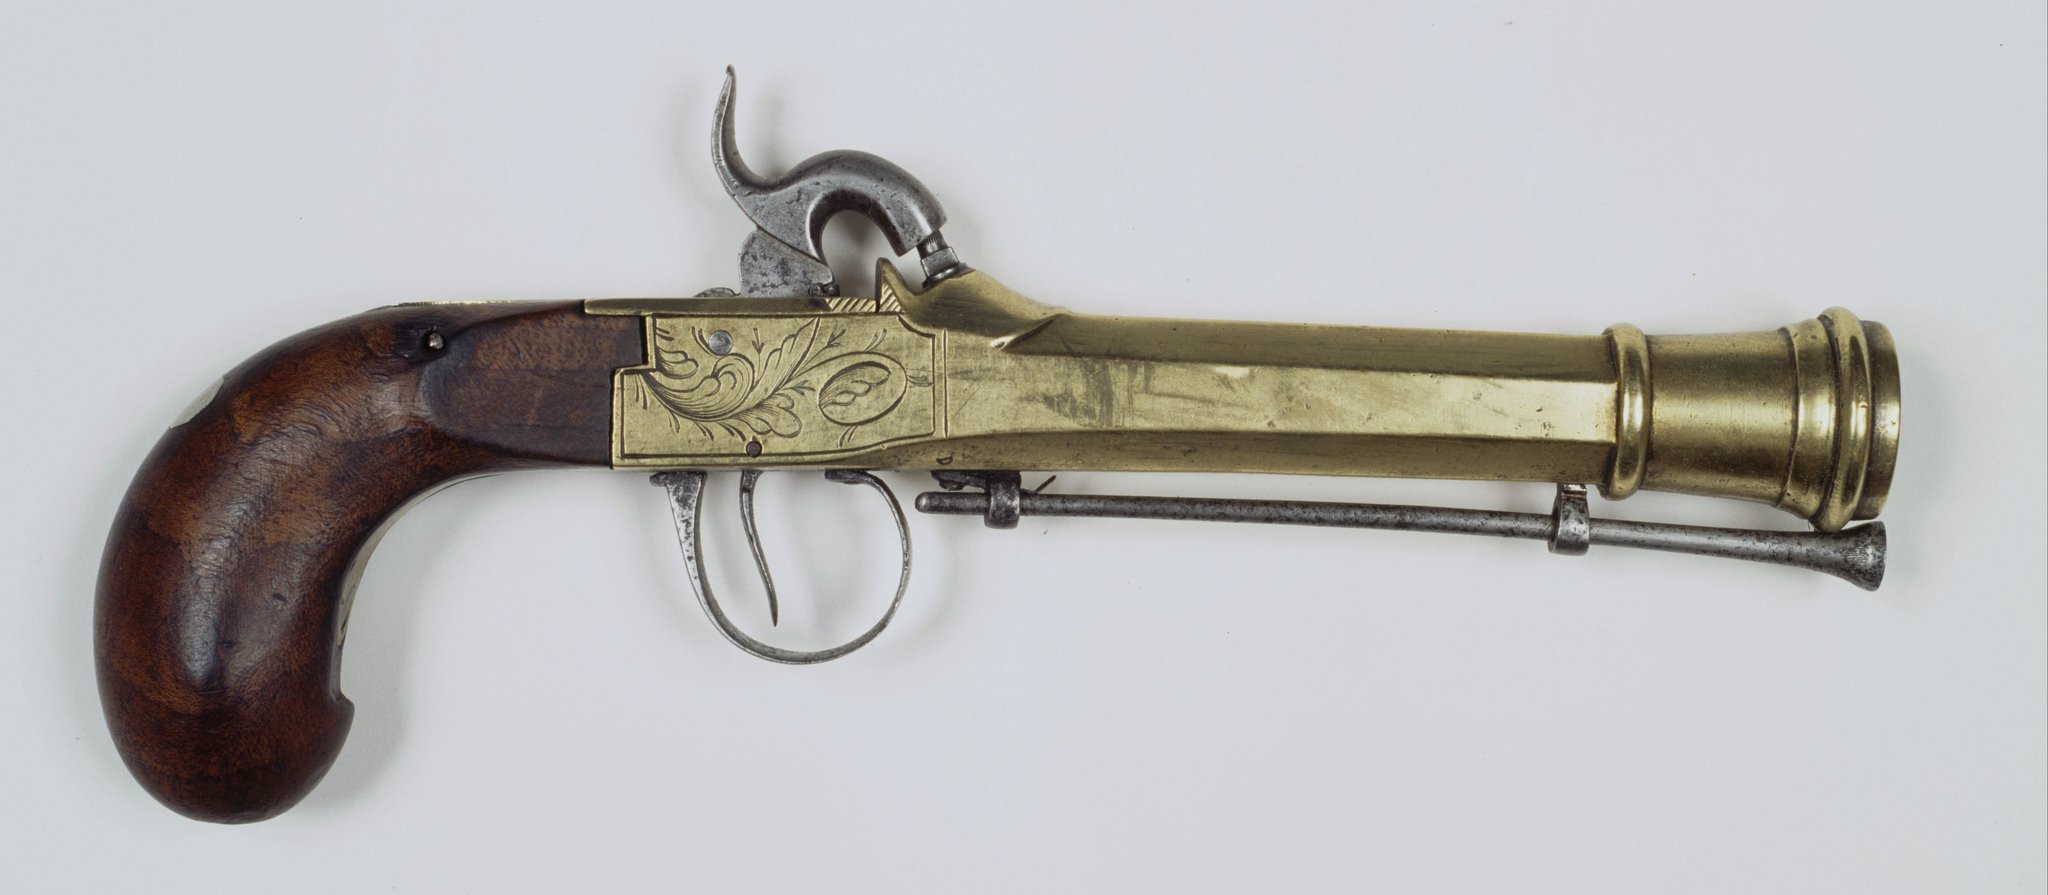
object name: percussion pistol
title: Percussiepistool met koperen loop, tromblon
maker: Anonymous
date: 1800-1900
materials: copper, iron, wood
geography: liège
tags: netherlands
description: Pistool met koperen loop, tromblon en percussieslot. Haan en schoortsteen boven. Het pistool draagt een Luiks merk: 'E' boven `L G' boven asterisk, geheel in ovaal. Alles is koper, behalve de haan, de schoorsteen de trekker, beugel en laadstok; de greep hout.